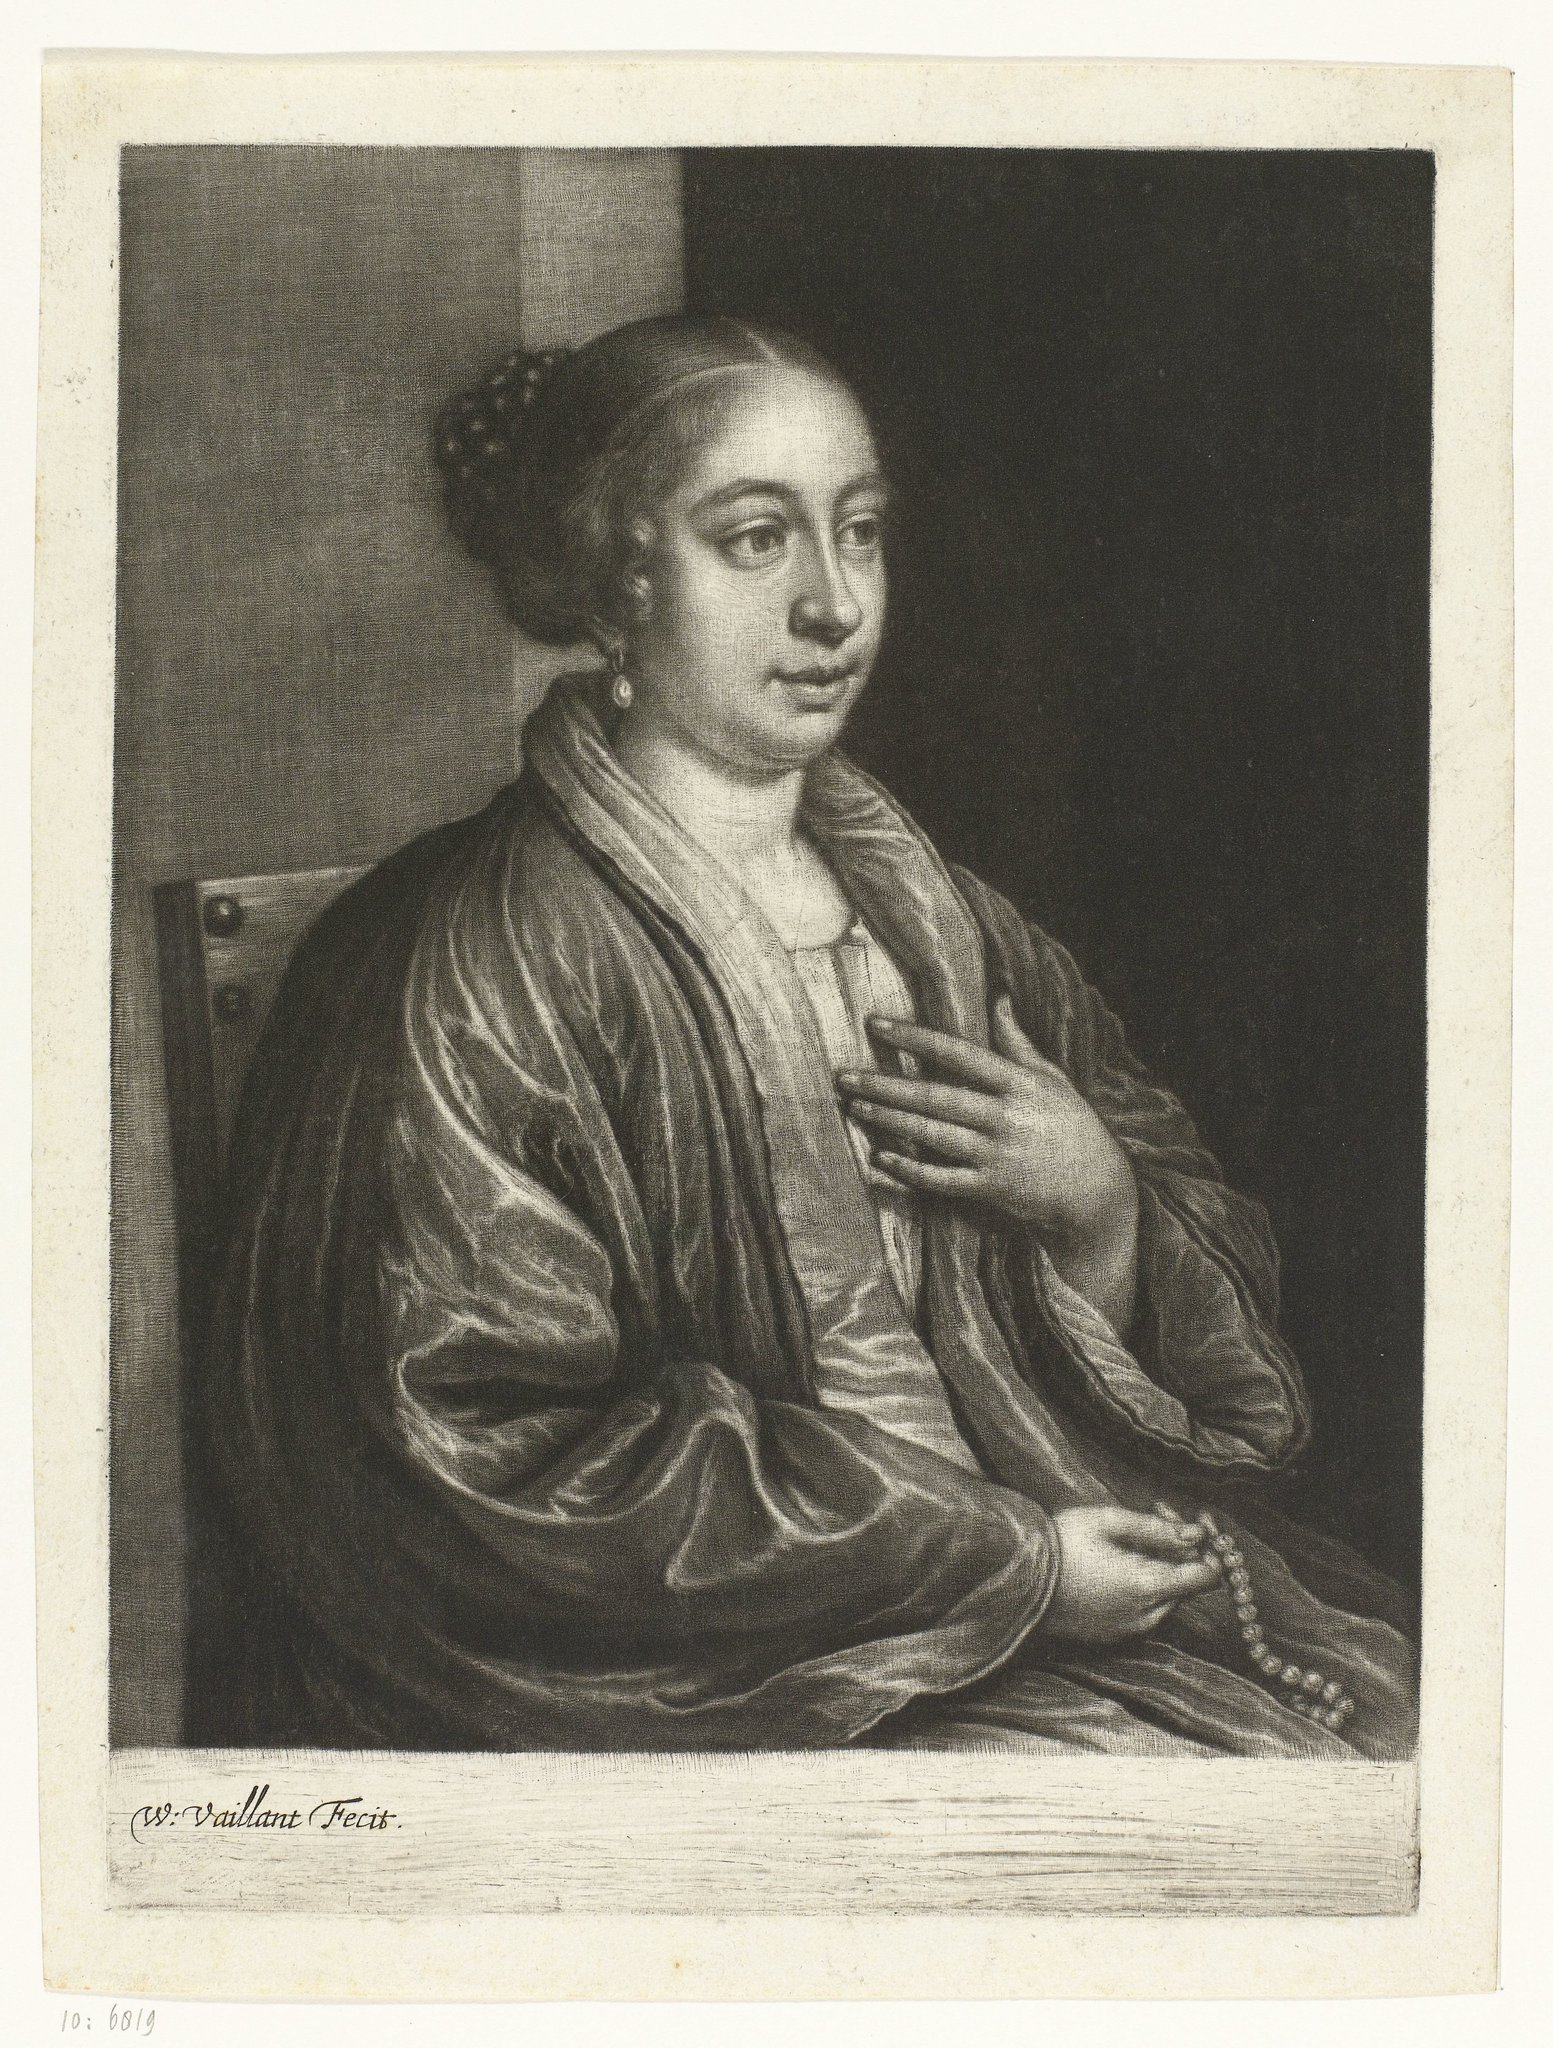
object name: print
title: Portret van een vrouw met een parelketting in de hand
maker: wallerant vaillant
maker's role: draughtsman, painter, print maker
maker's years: 1623-1677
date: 1658-1677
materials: paper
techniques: mezzotint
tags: pearl; pearl necklace (+ women's clothes)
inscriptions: collector's mark: Lugt 2228